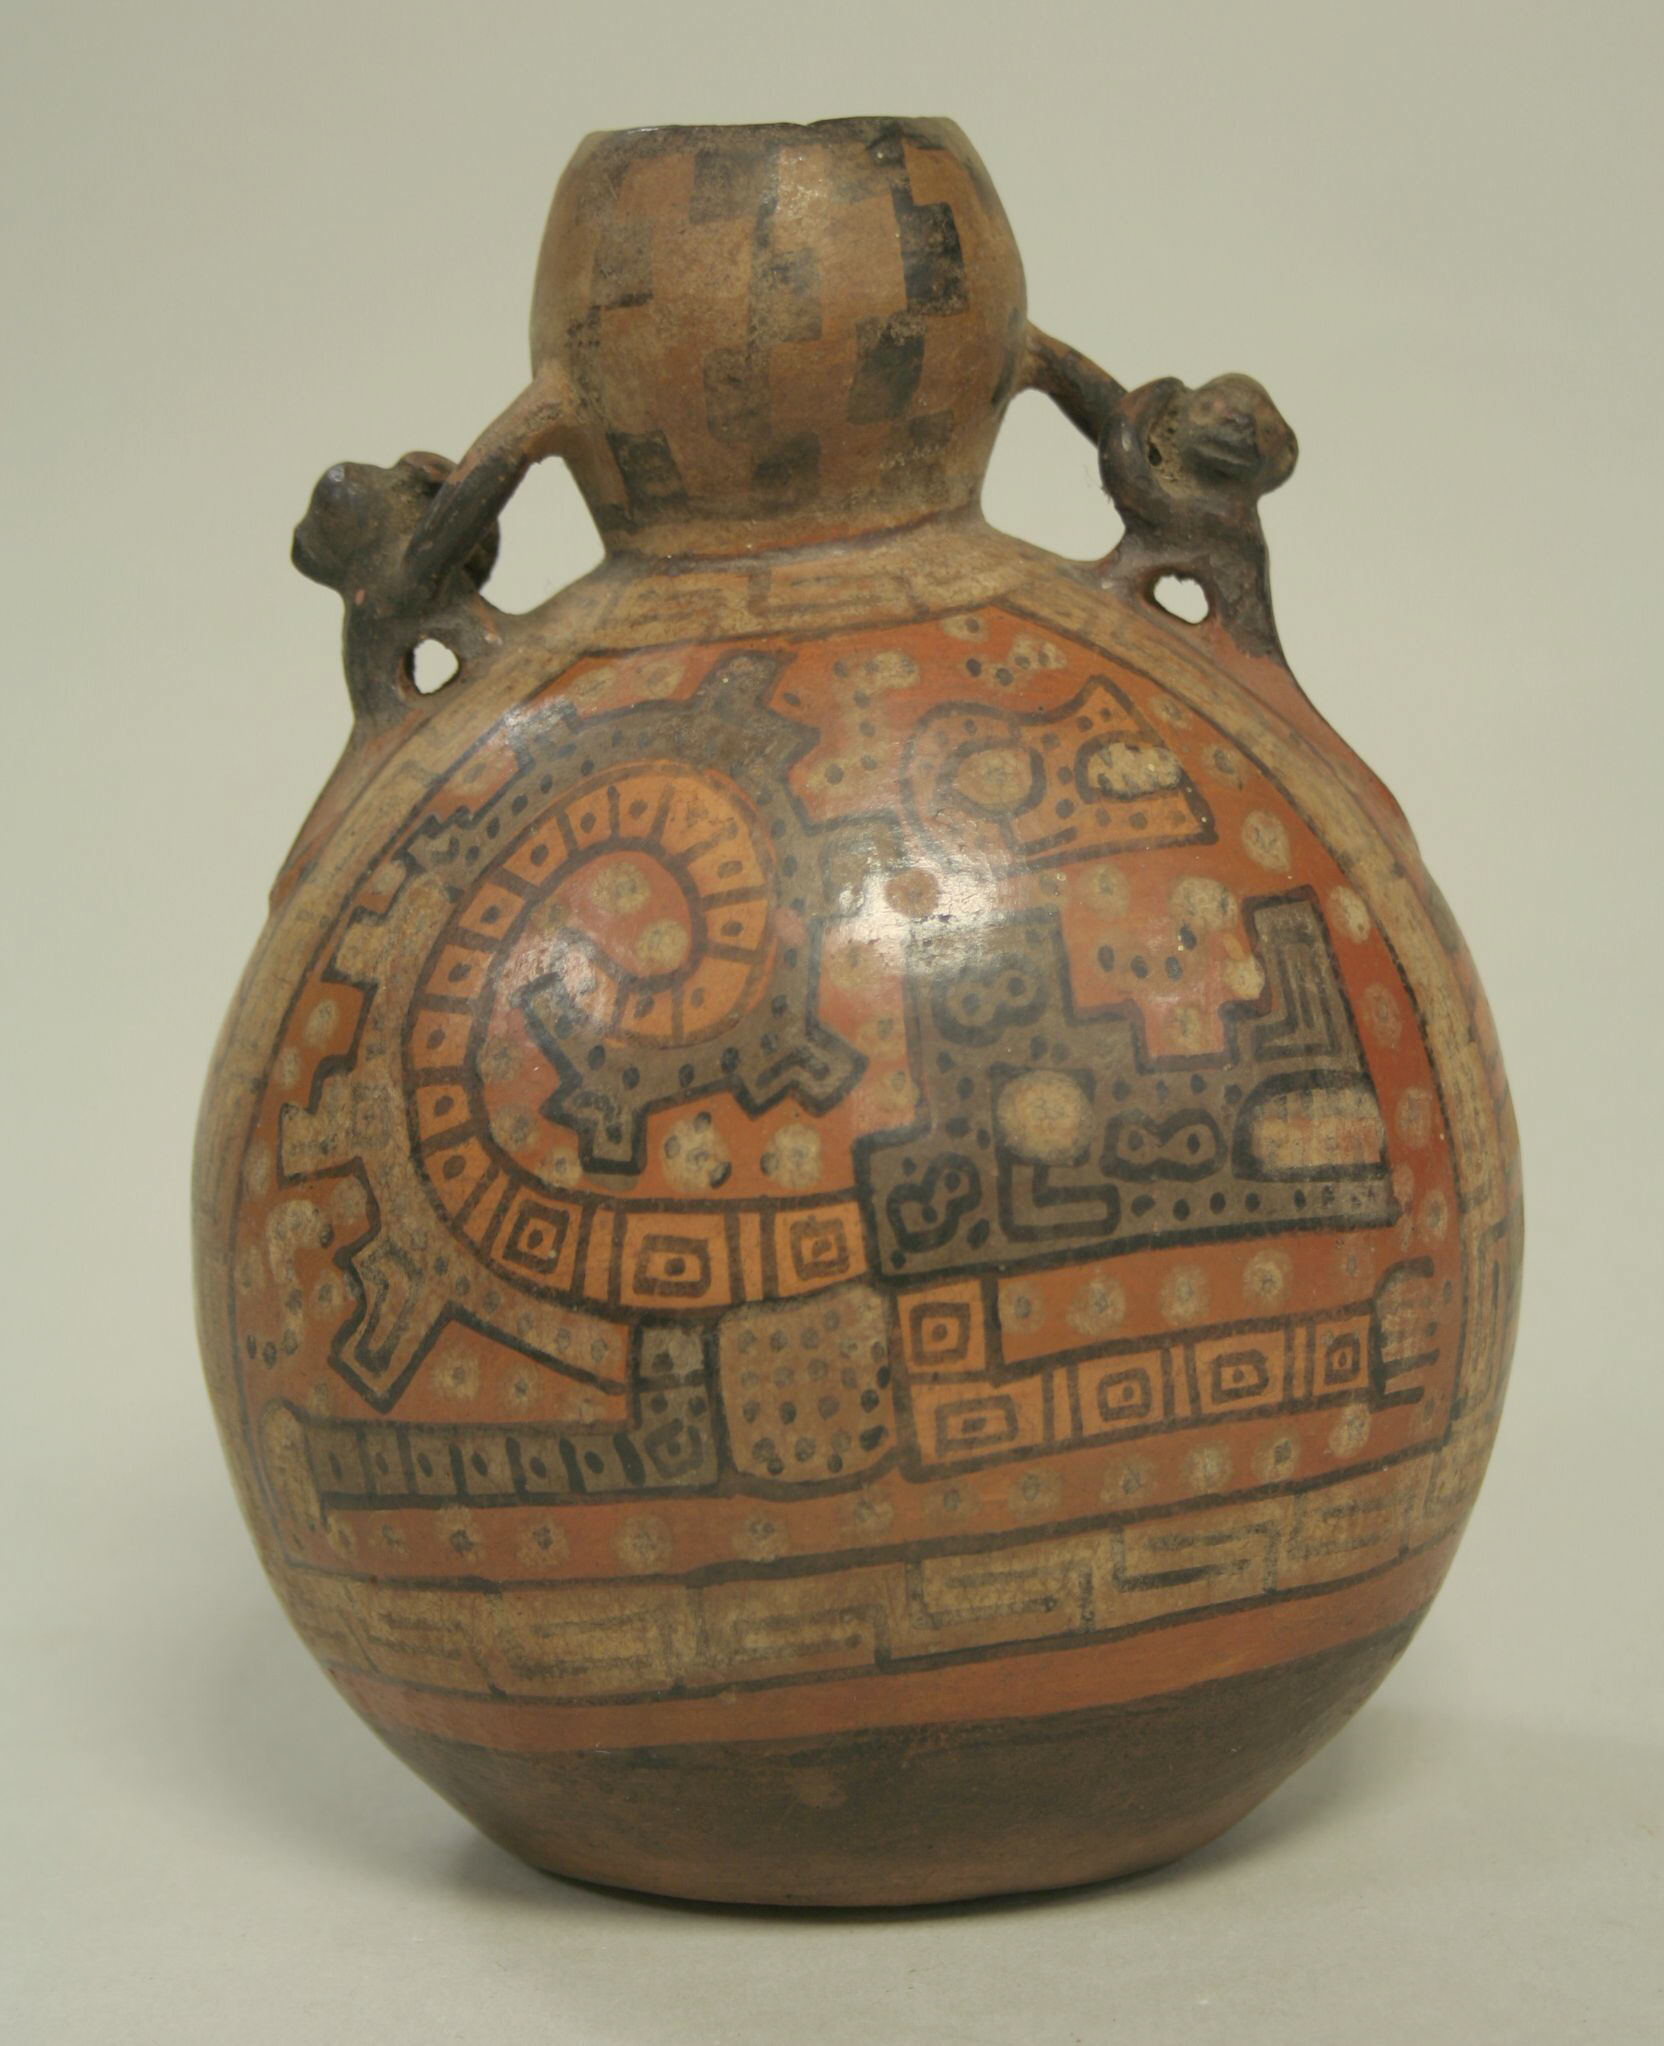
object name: bottle, miniature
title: Bottle, Monkey Handles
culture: wari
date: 501-1000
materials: ceramic, pigment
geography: peru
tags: monkeys